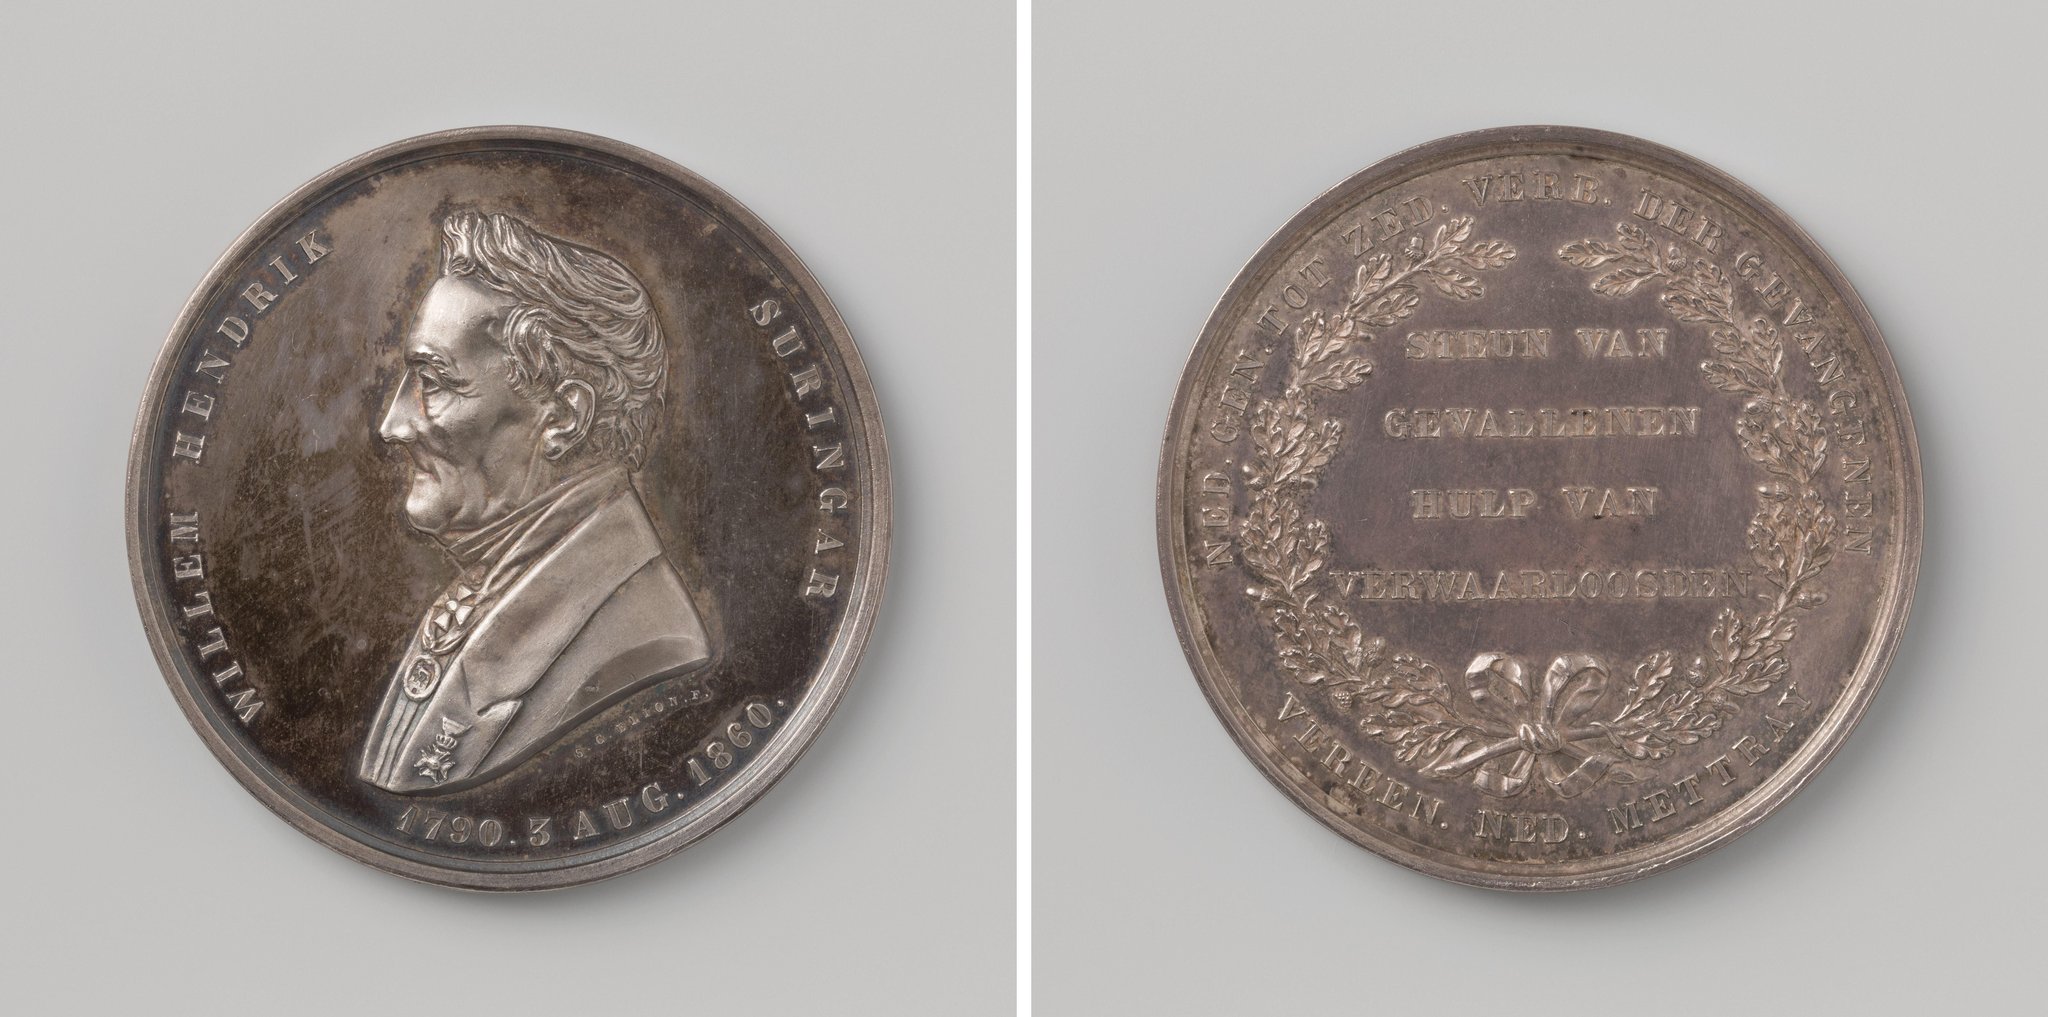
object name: verjaardagspenning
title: Zeventigste verjaardag van Willem Suringar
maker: samuel cohen elion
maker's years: 1815-1880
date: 1860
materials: silver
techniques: striking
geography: amsterdam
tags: leeuwarden, filantroop, willem hendrik suringar, nederlandsch genootschap tot zedelijke verbetering der gevangenen, vereeniging nederlandsch mettray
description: Zilveren penning. Voorzijde: borststuk man binnen omschrift. Keerzijde: opschrift binnen eikekrans en omschrift.